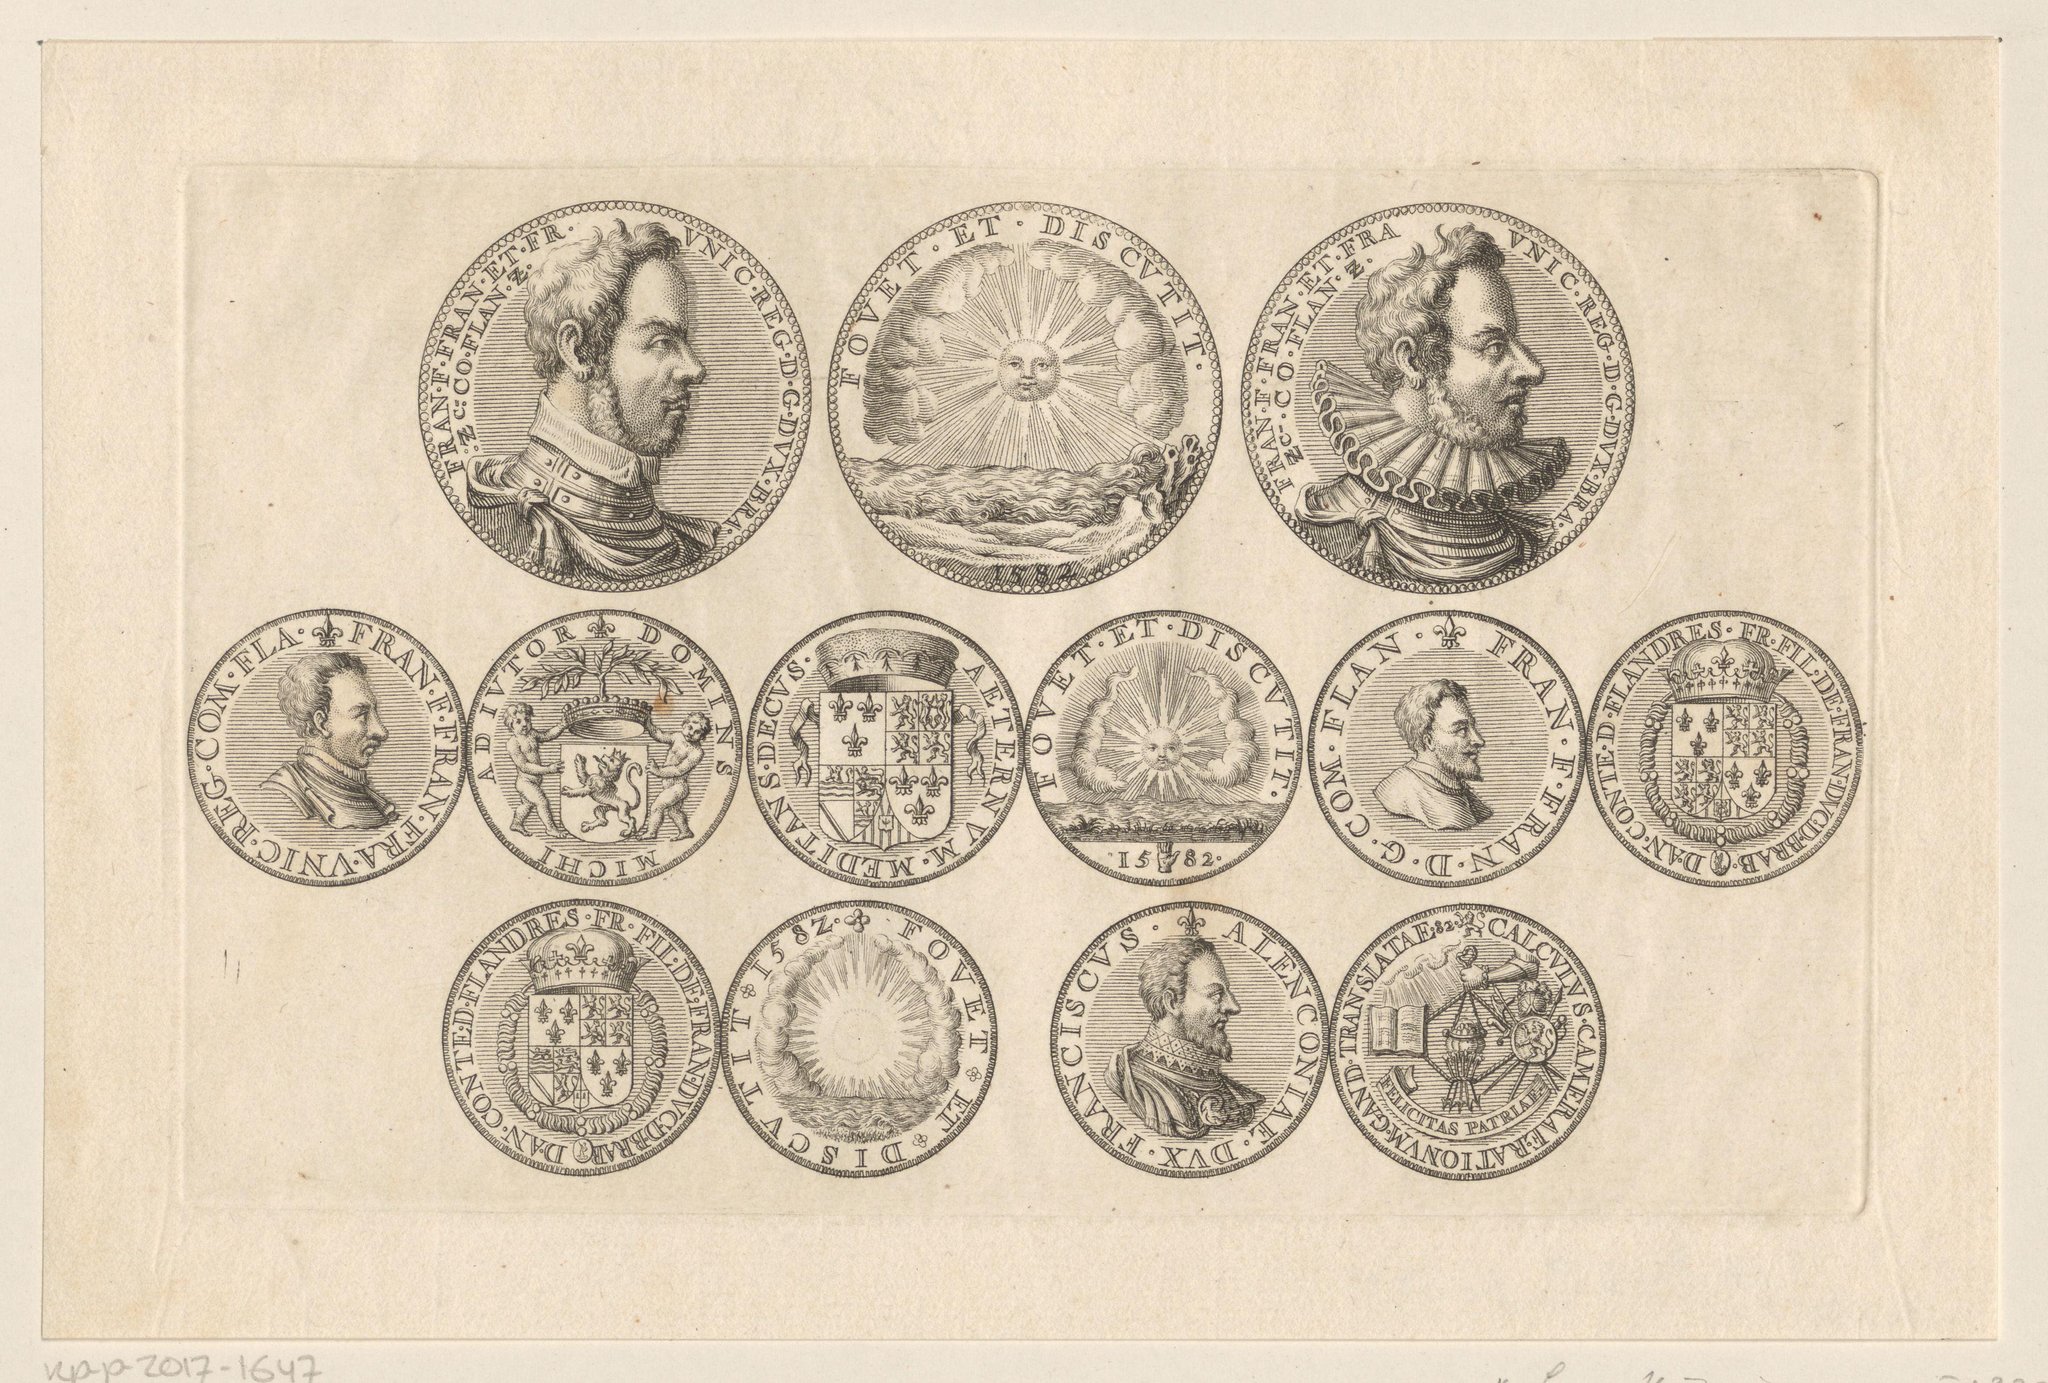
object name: print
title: Penningen met portretten van onder andere François-Hercule de Valois, hertog van Anjou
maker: Anonymous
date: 1700-1799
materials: paper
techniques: engraving, etching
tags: paris, françois-hercule de valois (hertog van anjou)